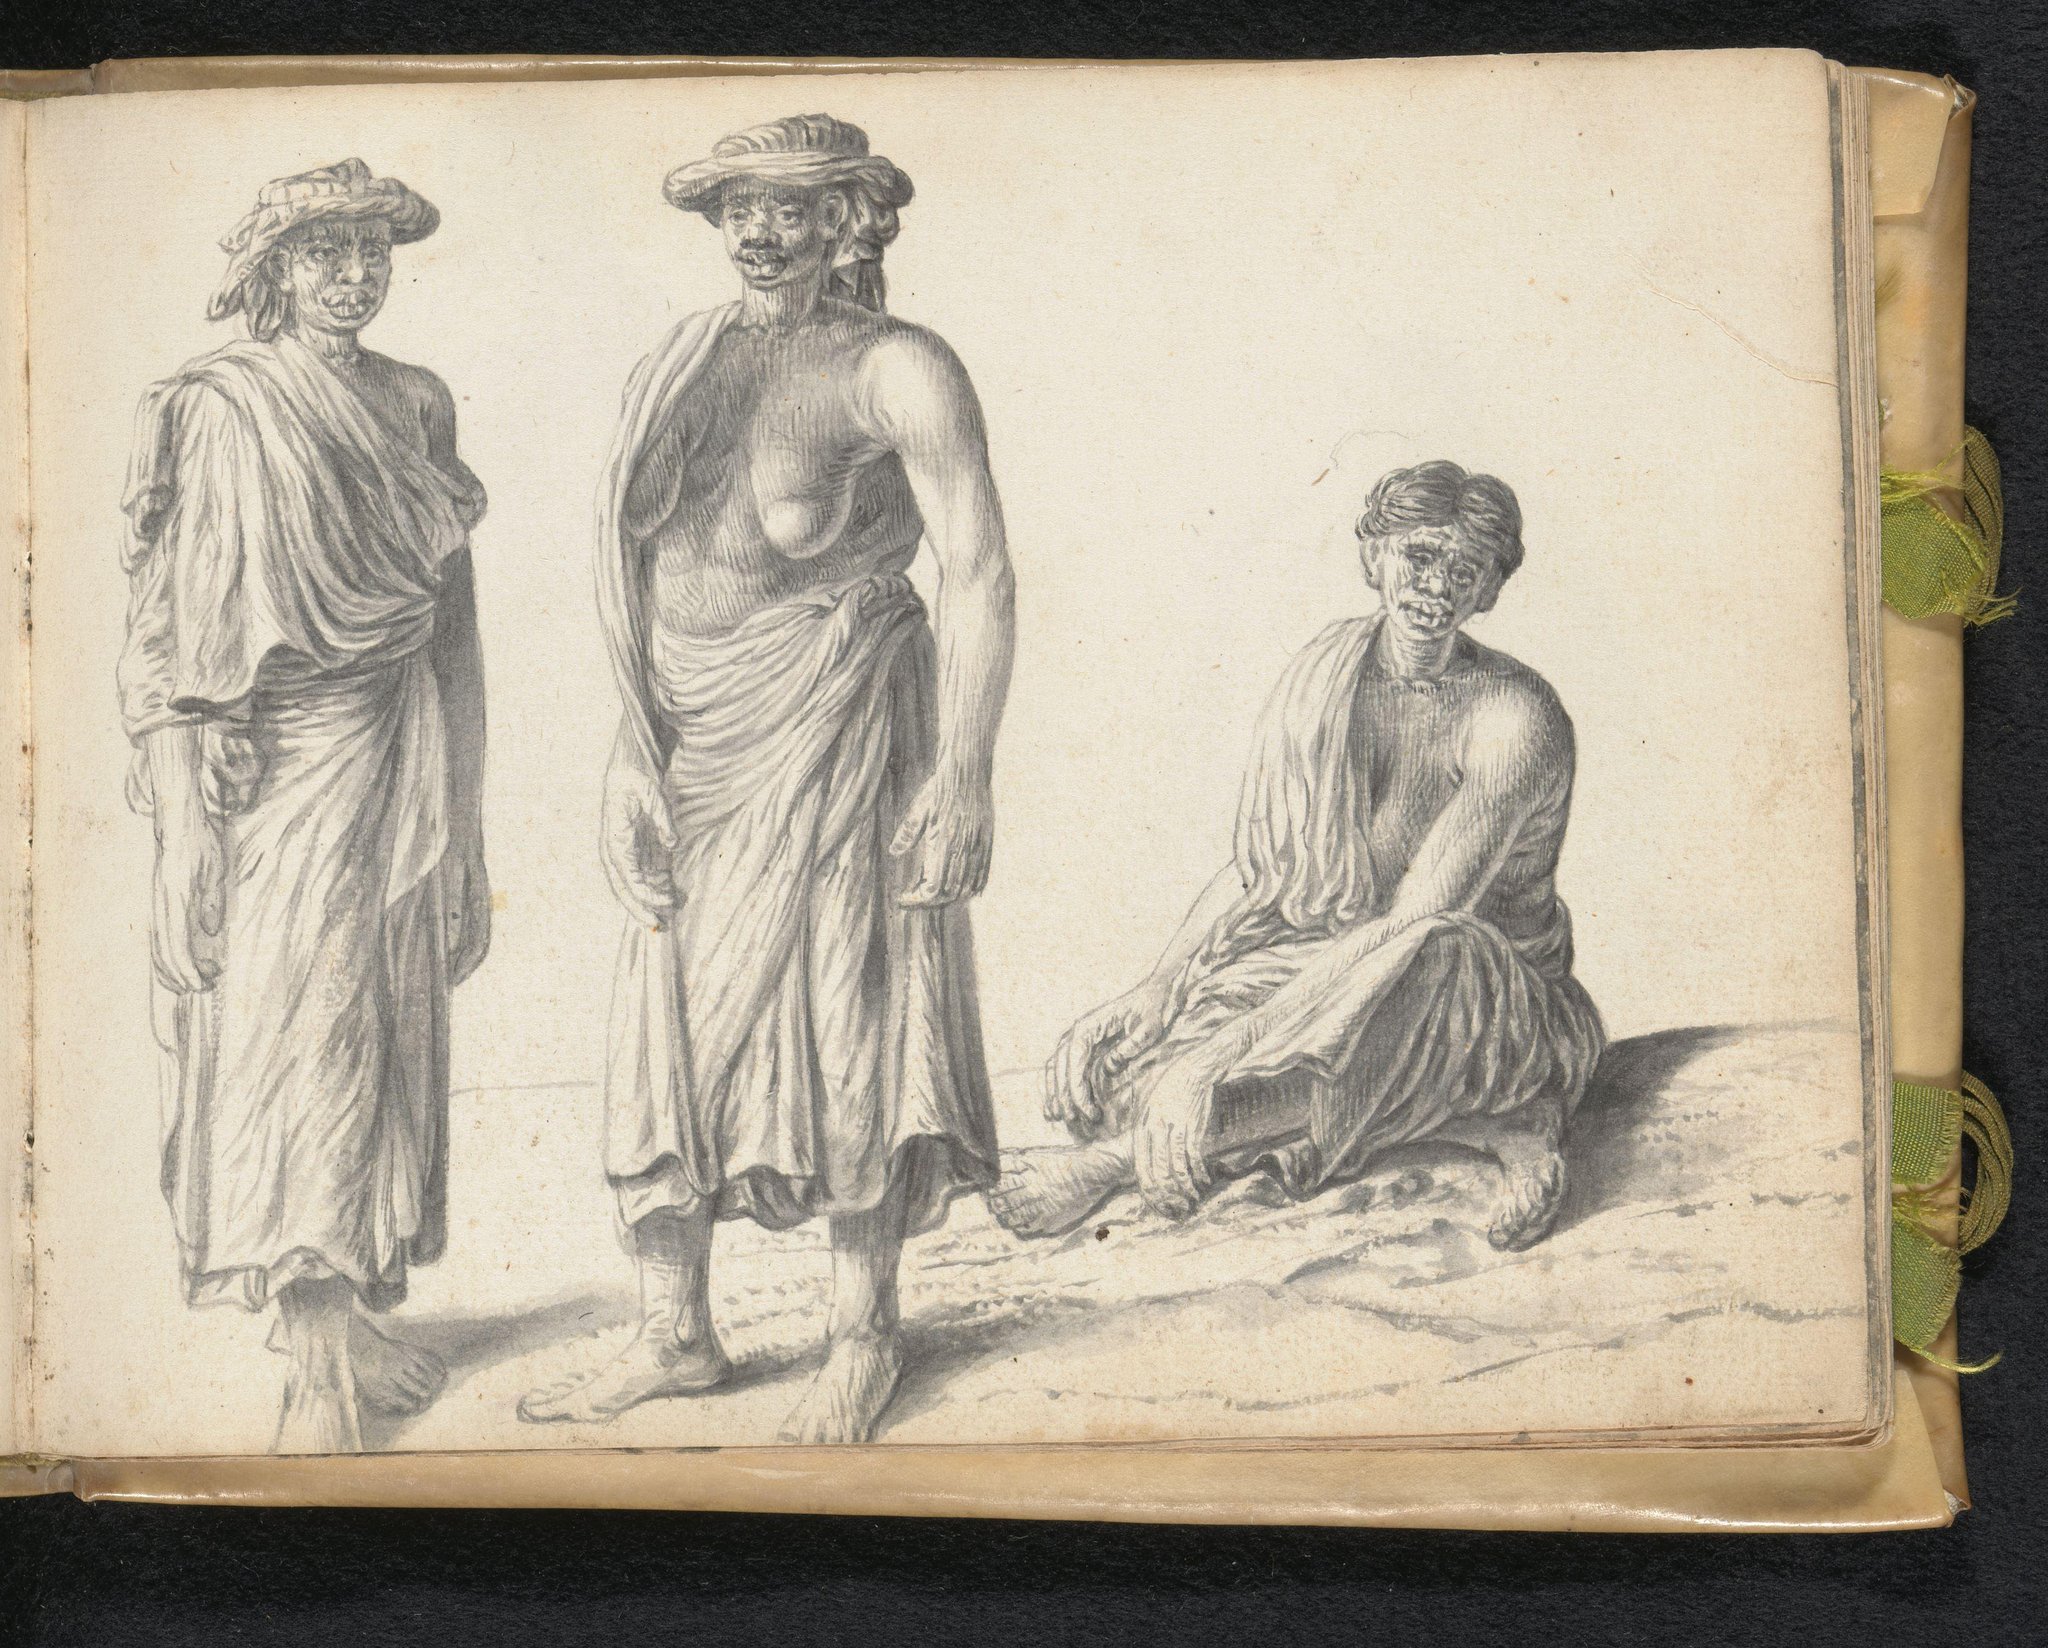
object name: sketchbook leaf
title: Three women labourers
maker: esaias boursse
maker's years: 1631-1672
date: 1662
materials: ink, paper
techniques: brush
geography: sri lanka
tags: asian races and peoples (with name), clothes covering the entire body (with name), styles of hairdress (with name) - ~women, asiatic races and peoples: indians, working class, labourers - aa - women, sri lanka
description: Buiten poseren twee staande en een zittende vrouw. Hun gezichten tonen Zuid-Indiase trekken. De vrouwen dragen een Zuid-Indiaas wikkelkleed (selai of sari) om hun middel gewikkeld, waarvan het uiteinde via de rug over de schouder naar voren is geslagen. Bij de vrouw links bedekt het haar rechterschouder en gehele bovenlijf. Op haar hoofd heeft ze een hoofddoek gevouwen. De vrouw in het midden heeft alleen haar rechterschouder bedekt maar laat haar borsten bloot. Ook zij heeft haar hoofd en haar bedekt met een brede geplooide hoofddoek. De vrouw rechts zit met gekruiste knieën op de grond. Het uiteinde van de heupdoek valt over haar rechterschouder en bedekt gedeeltelijk haar borsten. Ze heeft golvend haar, in het midden gescheiden en naar achter getrokken in een wrong (condé). Blad 97 uit een schetsboek met 117 bladen.